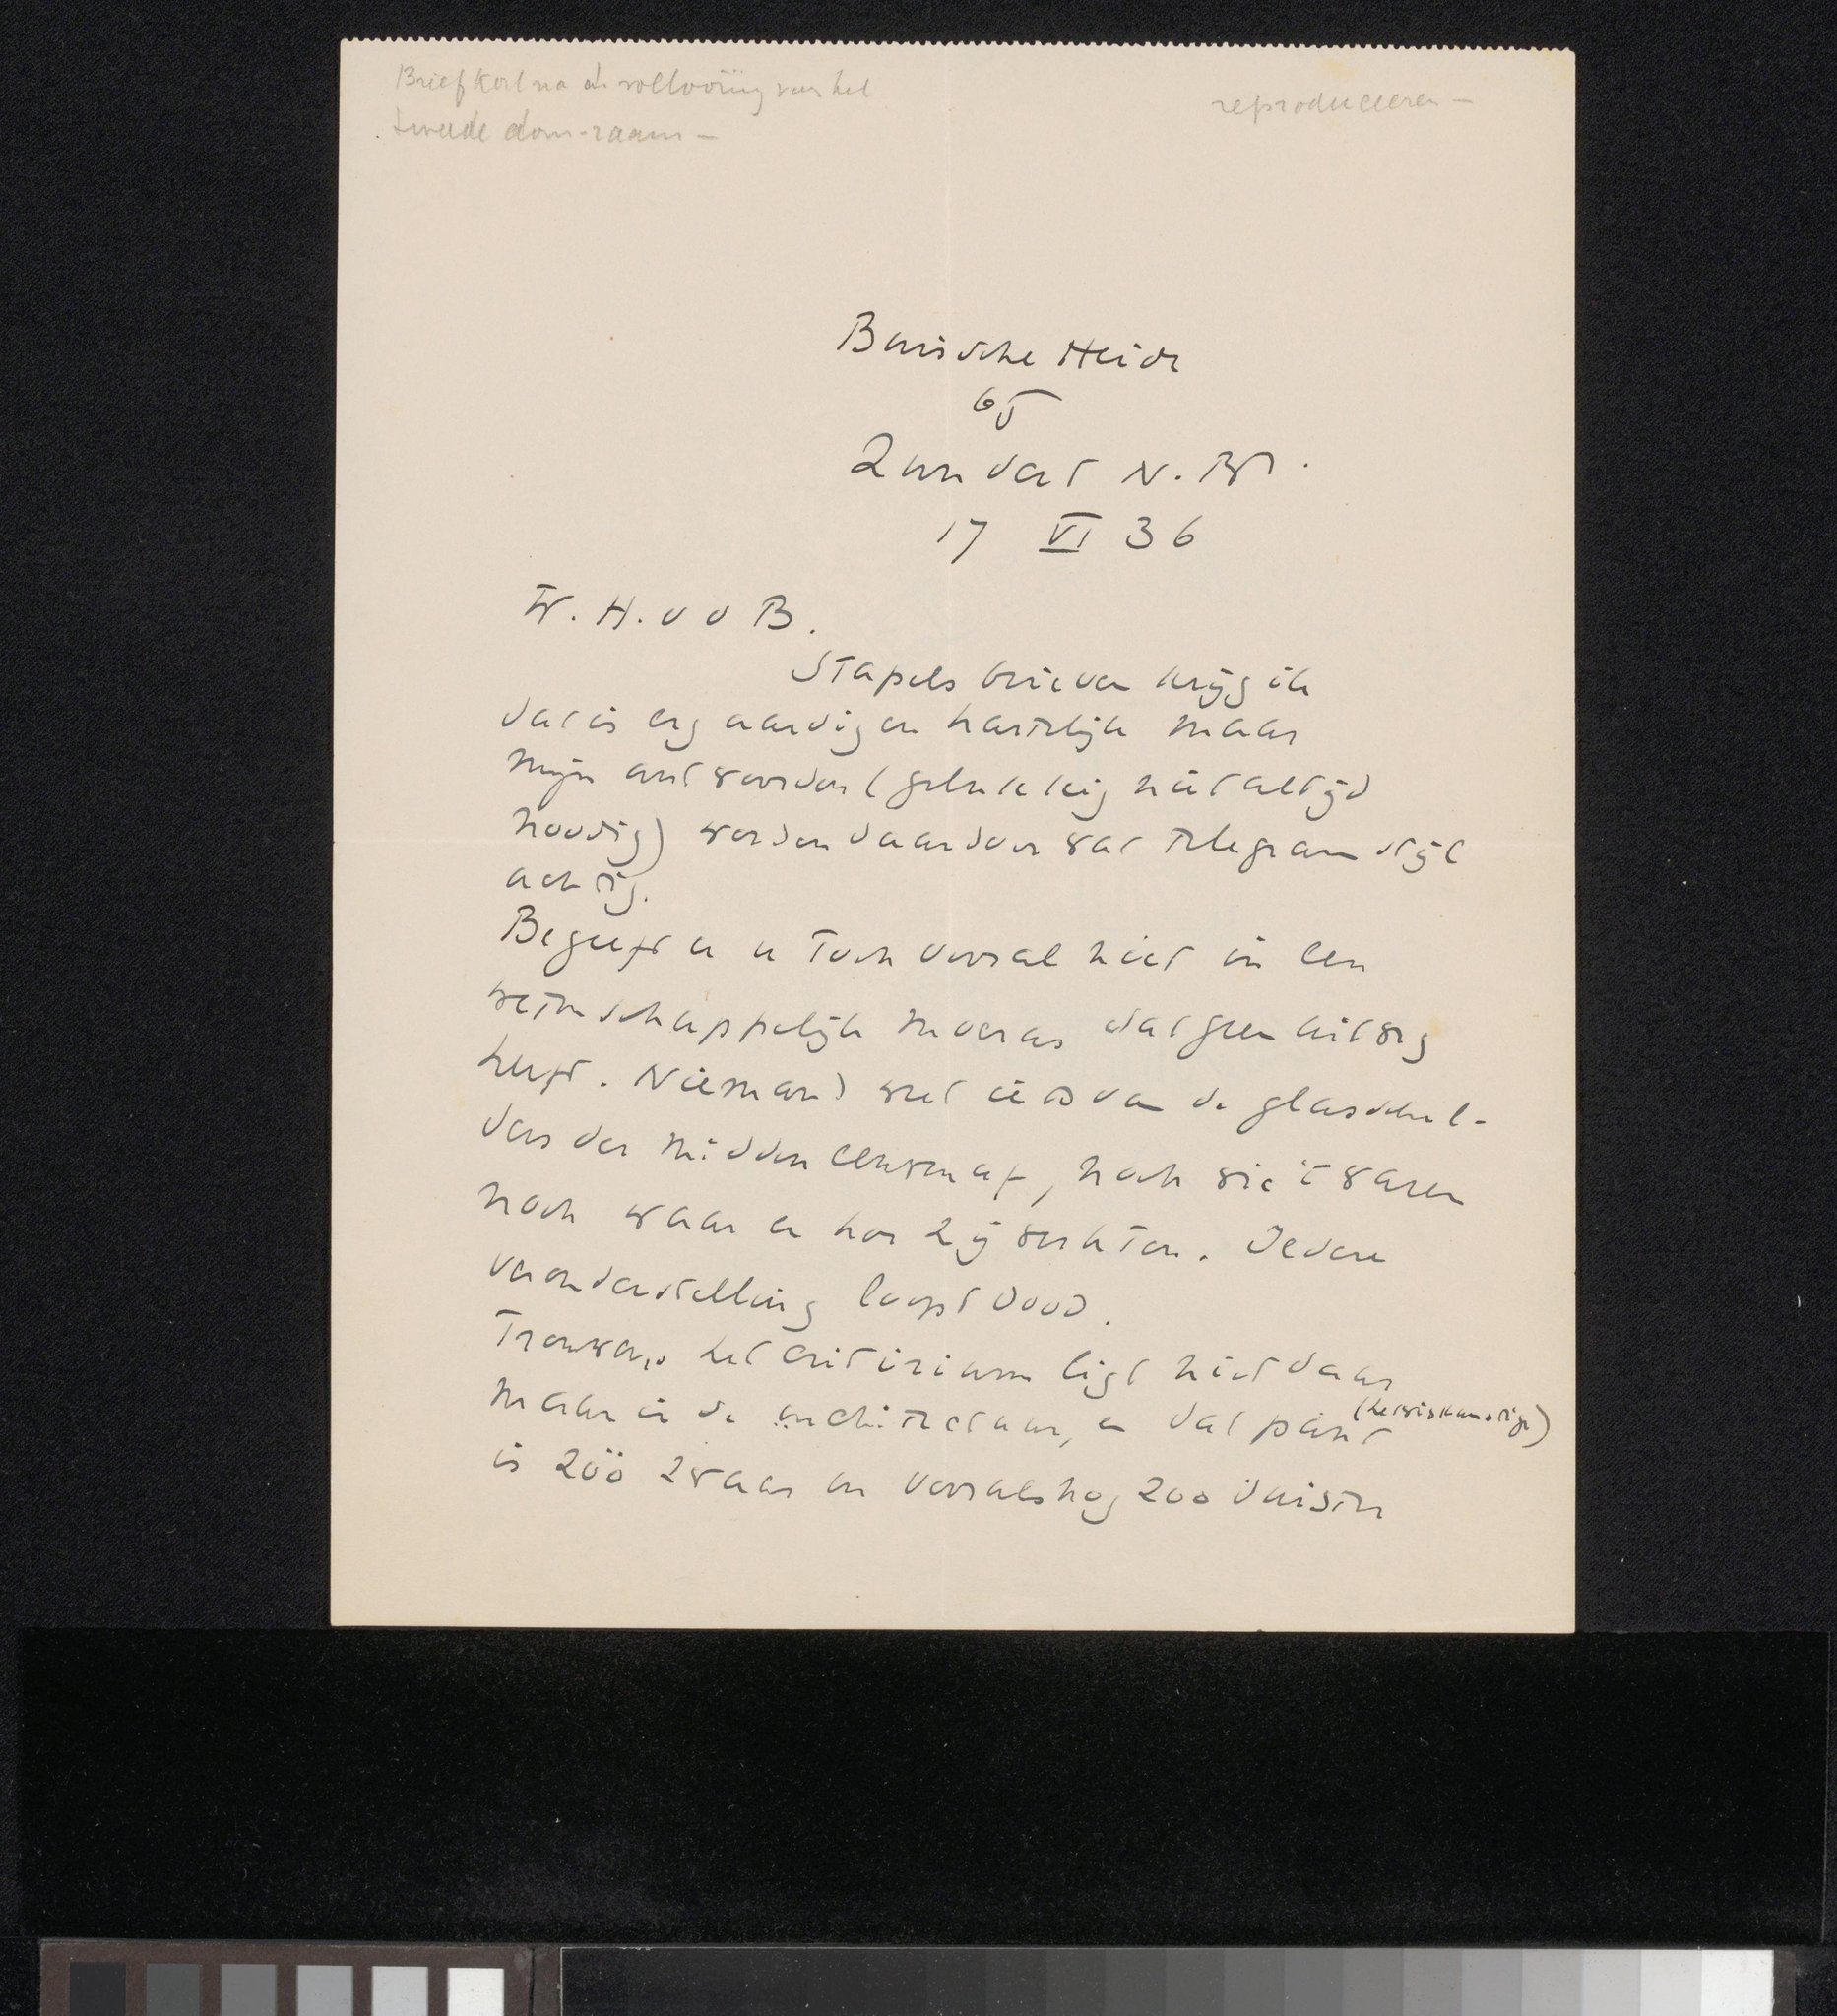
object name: letter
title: Brief aan A. van der Boom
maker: richard nicolaüs roland holst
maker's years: 1868-1938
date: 1936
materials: ink, paper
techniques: pen, writing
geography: buissche heide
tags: a. van der boom, applied arts, arts and crafts; industrial design, photography, cinematography, architecture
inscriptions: collector's mark: Lugt L.2228a, watermark